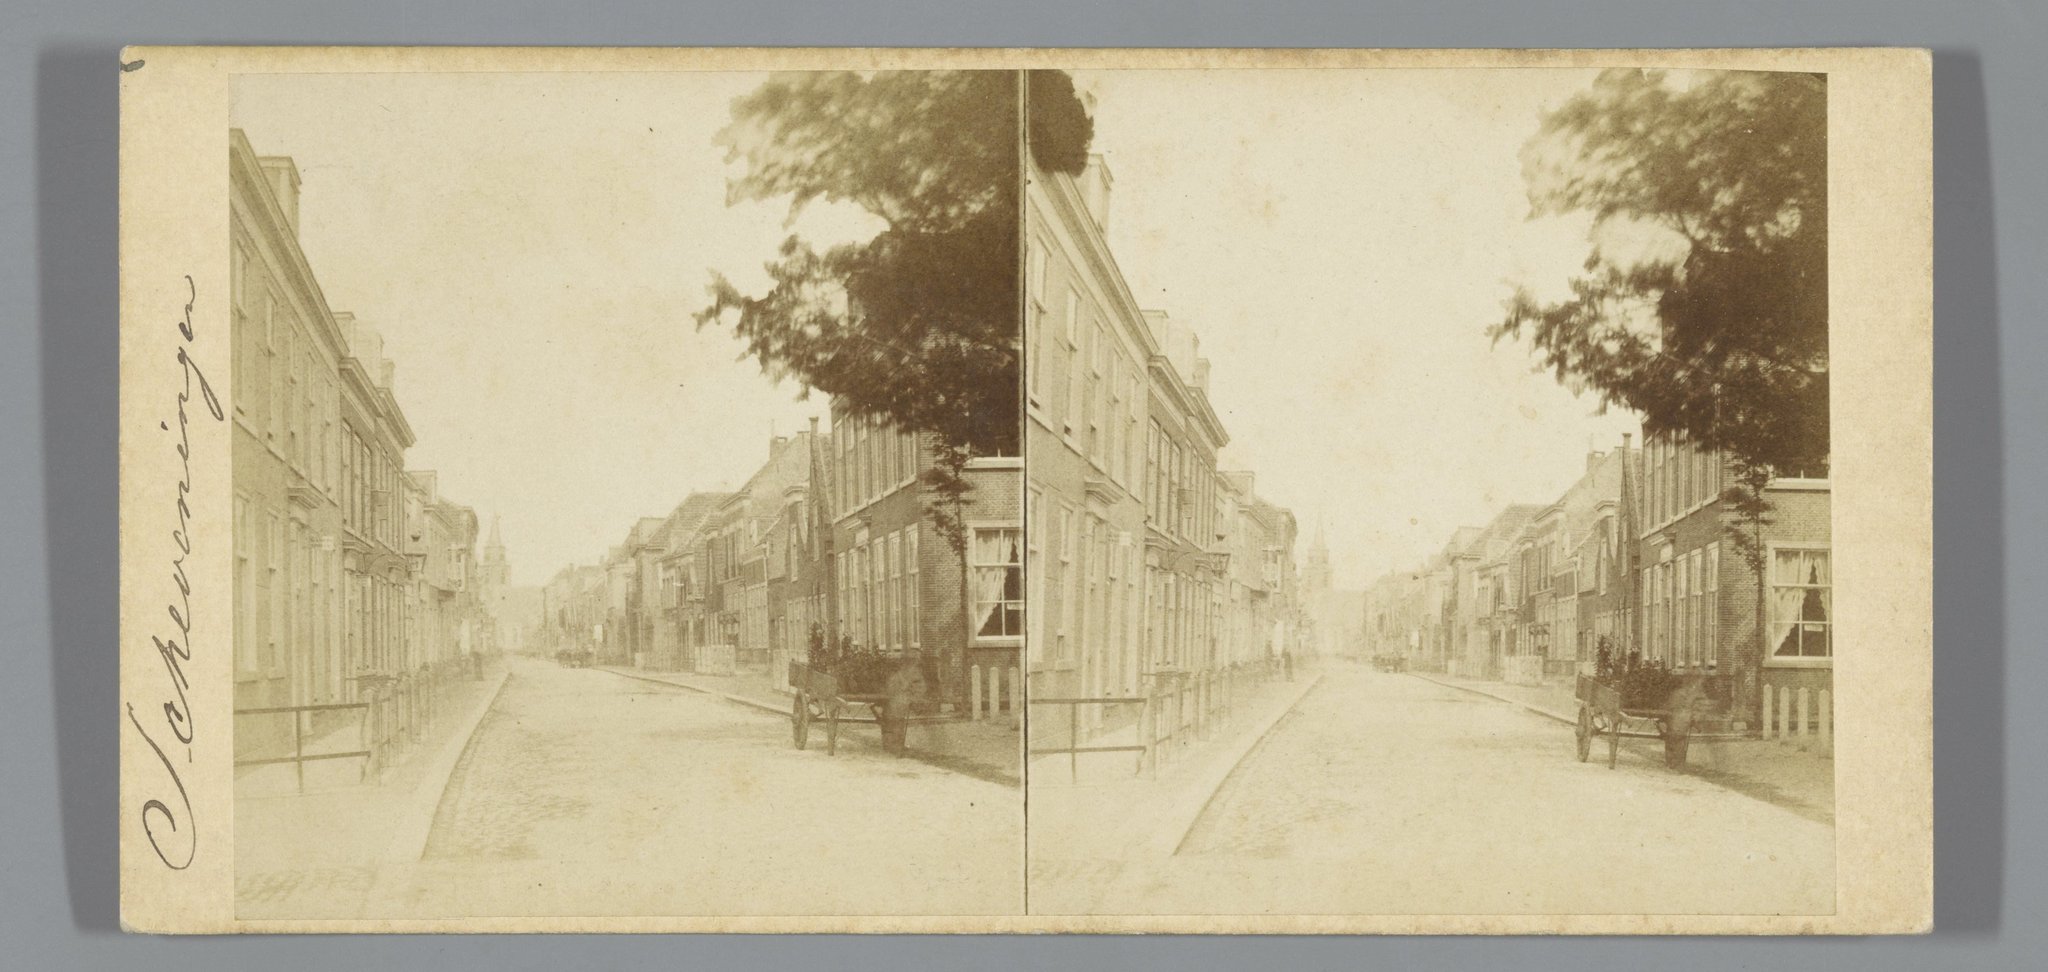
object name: stereograph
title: Scheveningen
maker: pieter oosterhuis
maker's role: draughtsman, print maker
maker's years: 1816-1885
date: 1859-1865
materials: cardboard, paper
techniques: albumen print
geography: scheveningen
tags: street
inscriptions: inscription: ‘Scheveningen’, number: ‘No. 235.’, number: ‘3’, inscription: ‘P.’